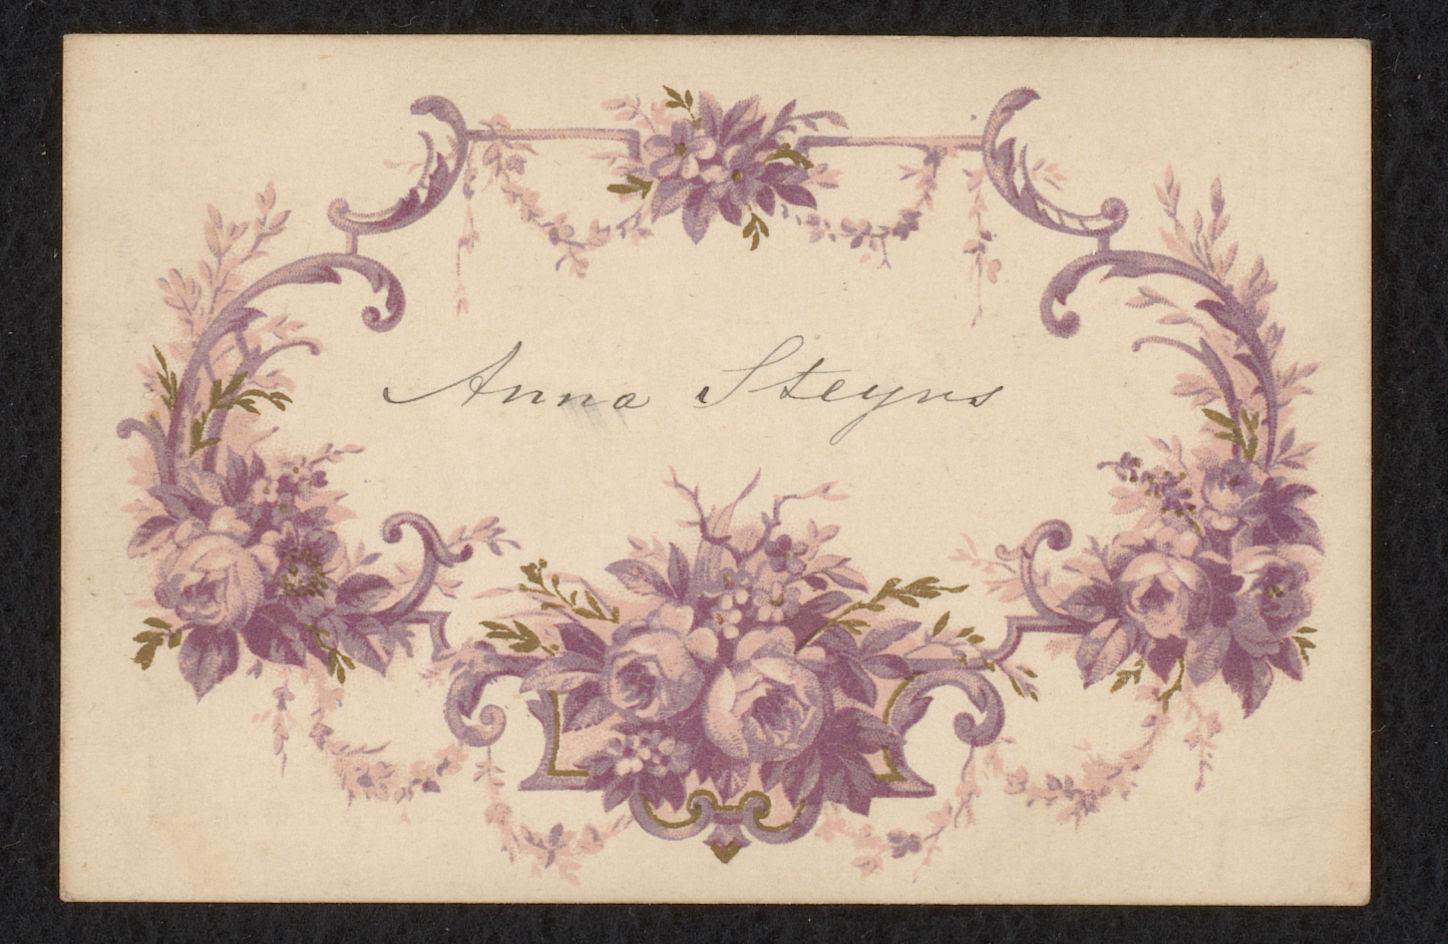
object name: print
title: Menu van een diner op 18 maart 1888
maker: Anonymous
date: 1888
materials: paper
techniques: chromolithography, letterpress printing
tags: anna steyns, flowers: rose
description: Op de voorzijde, in een decoratief kader van rozen, de naam 'Anna Steyns' in handschrift. Op de achterzijde, binnen een decoratief kader, het menu van het diner.